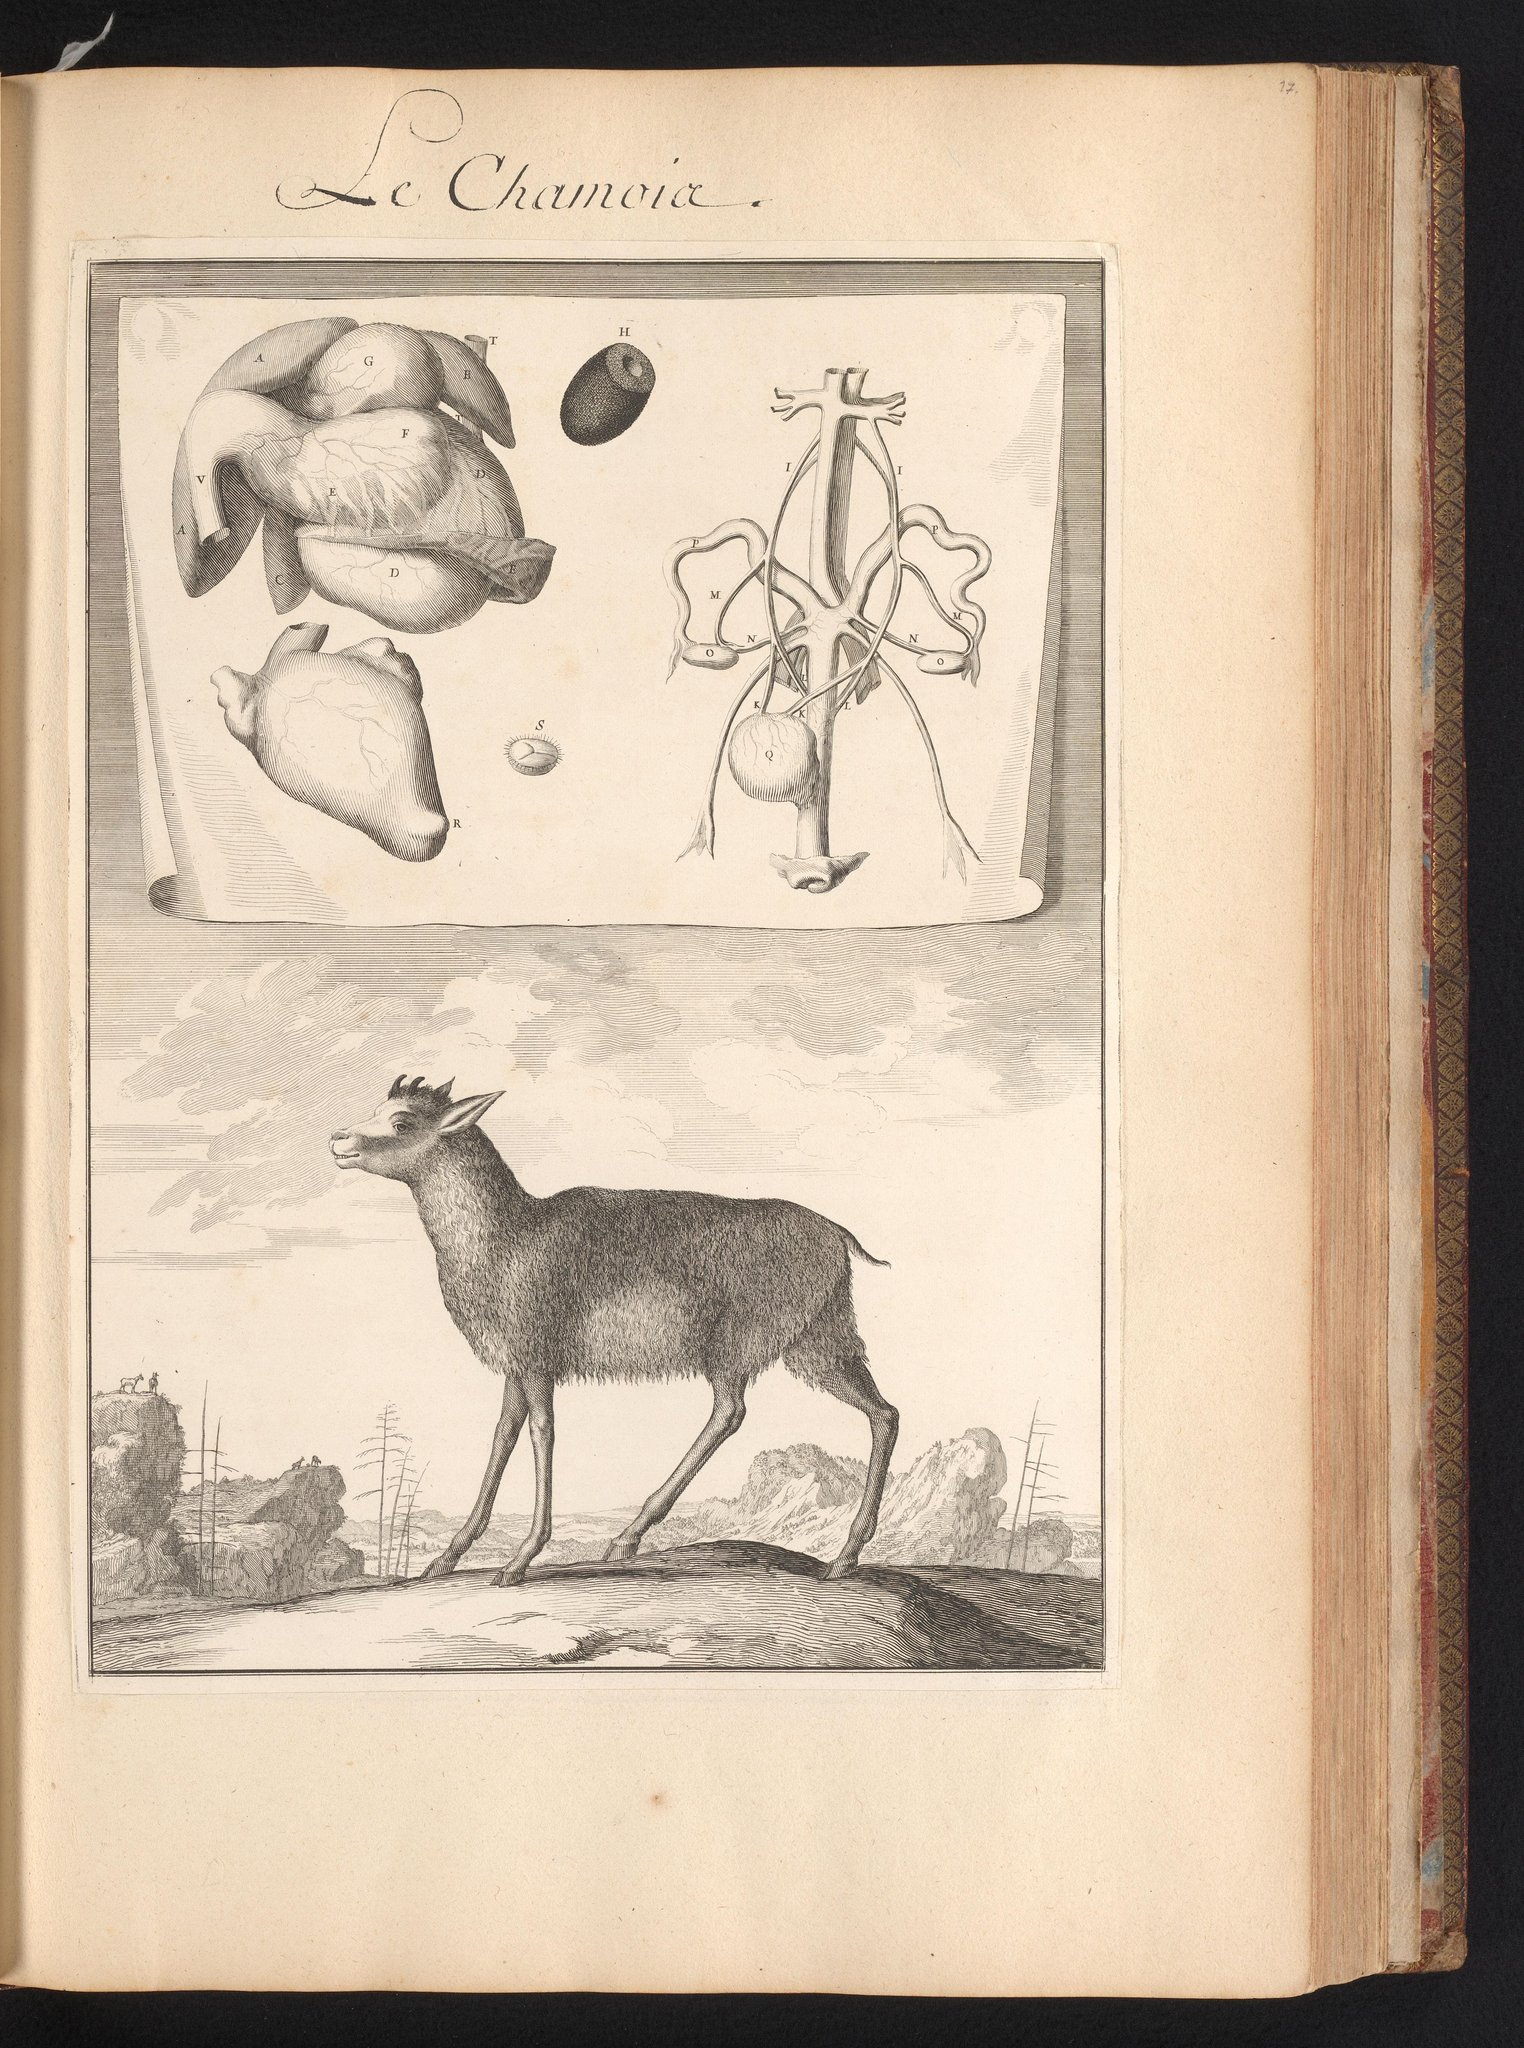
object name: album leaf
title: Gems (rupicapra rupicapra) in een landschap met bovenaan op een blad de organen en botten van het dier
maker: sébastien leclerc (i)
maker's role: print maker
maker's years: 1637-1714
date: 1676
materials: ink, paper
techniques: engraving, etching, pen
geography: paris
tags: dissection, hoofed animals, hoofed animals (+ anatomy of animals)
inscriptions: inscription: ‘Le Chamois.’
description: Prent uit: Perrault, Claude. Mémoires pour servir à l'histoire naturelle des animaux. Dressez par M. Perrault de l'Académie Royale des Sciences (...). Parijs: Imprimerie Royale, 1676.